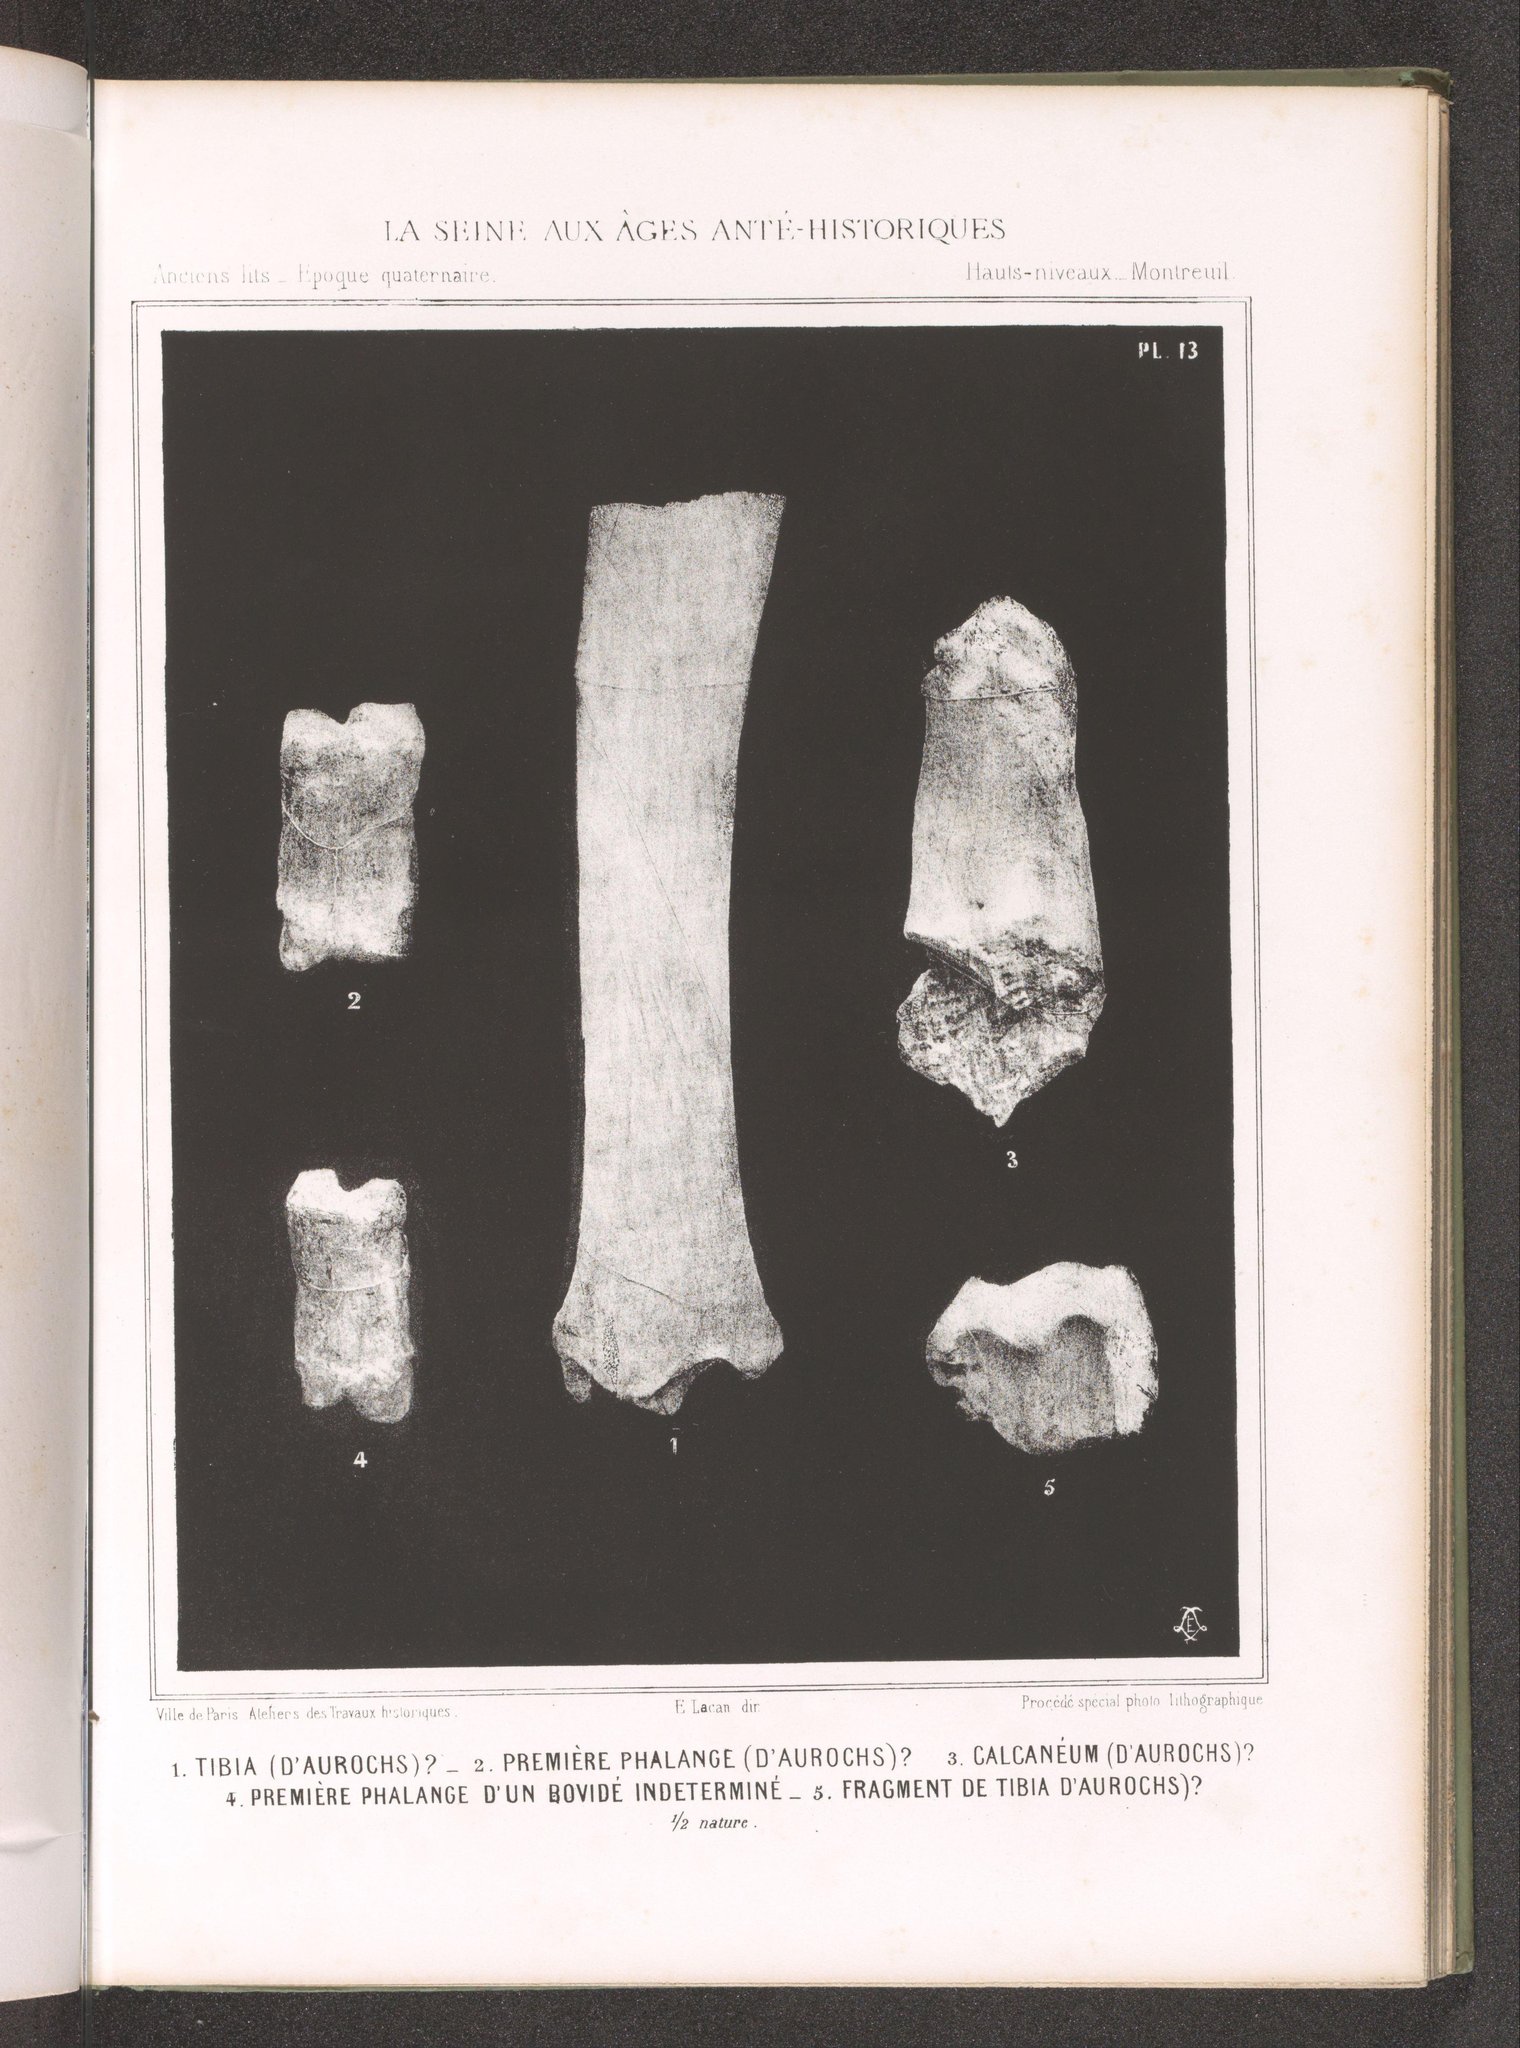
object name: page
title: 1. TIBIA (D'AUROCHS)? _ 2. PREMIÈRE PHALANGE (D'AUROCHS)? 3. CALCANÉUM (D'AUROCHS) ? 4. PREMIÈRE PHALANGE D'UN BOVIDÉ INDETERMINÉ _ 5. FRAGMENT DE TIBIA D'AUROCHS)? 1/2 nature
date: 1860-1869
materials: paper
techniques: photolithography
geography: france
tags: animals (+ skeleton of an animal), palaeontology, france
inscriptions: number: ‘Pl. 13’, inscription: ‘Ville de Paris. Atelier des Travaux historiques E. Lacan, dir. Procédé spécial photo-lithographique.’, monogram: ‘LEL’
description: Voor plek prent in boek: zie nummer onder 'Opschriften / Merken'.